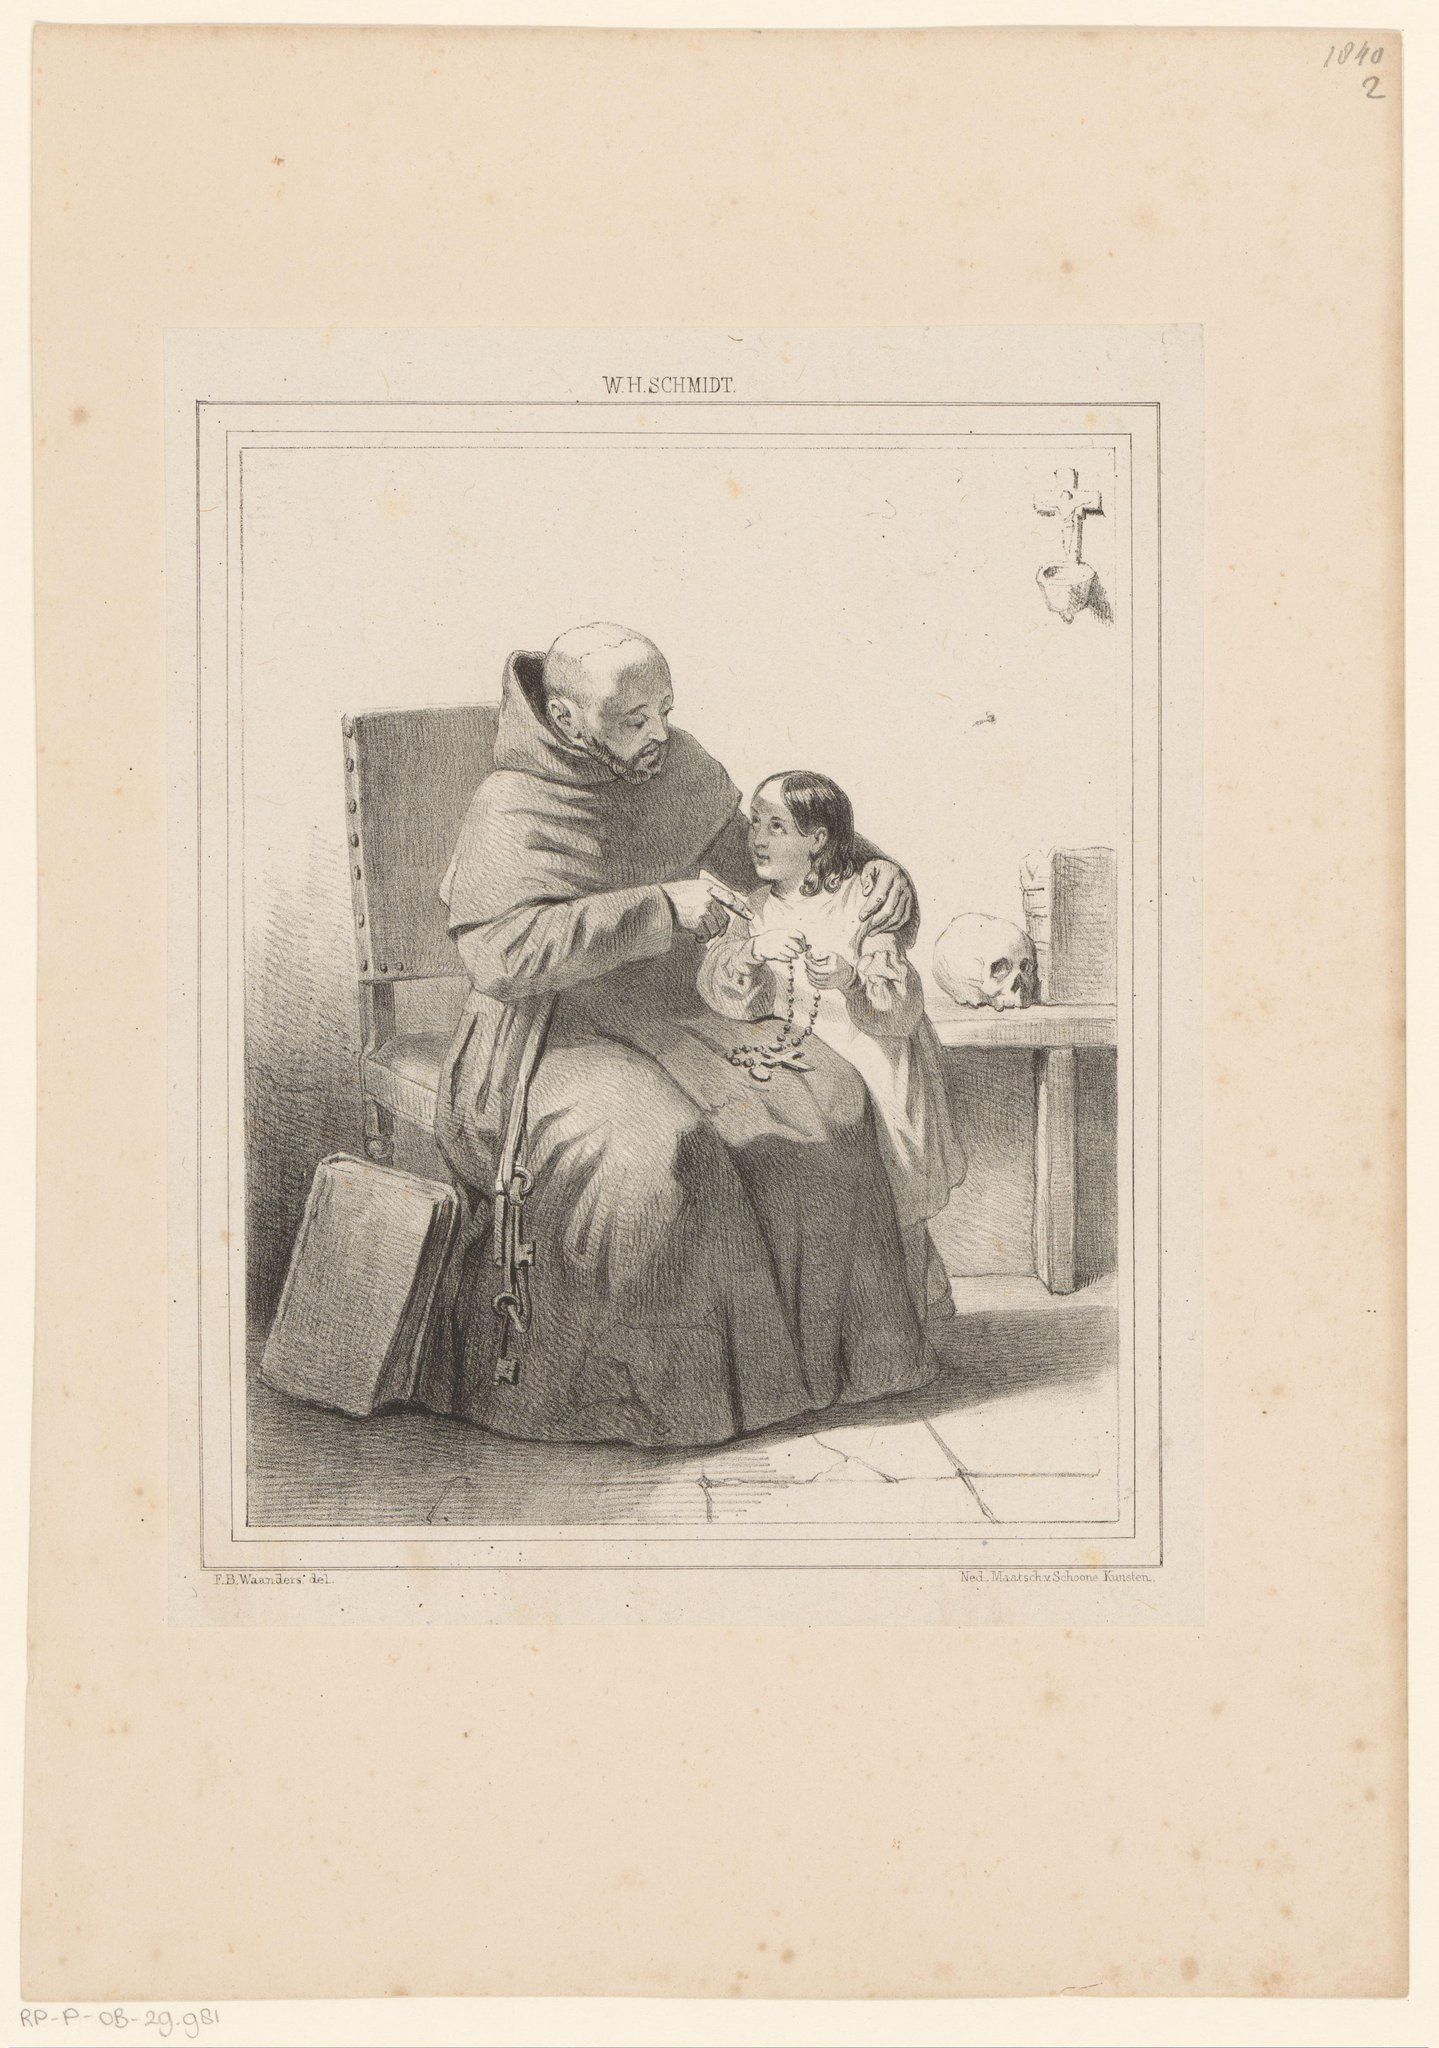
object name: print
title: Het godsdienstig onderwijs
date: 1840-1841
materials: paper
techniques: lithograph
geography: the hague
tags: monk(s), friar(s)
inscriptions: collector's mark: Lugt 2228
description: Naast een zittende monnik staat een meisje met rozenkrans. Tegen de stoel staat een bijbel. Rechts staat een tafel waarop een boek en schedel.